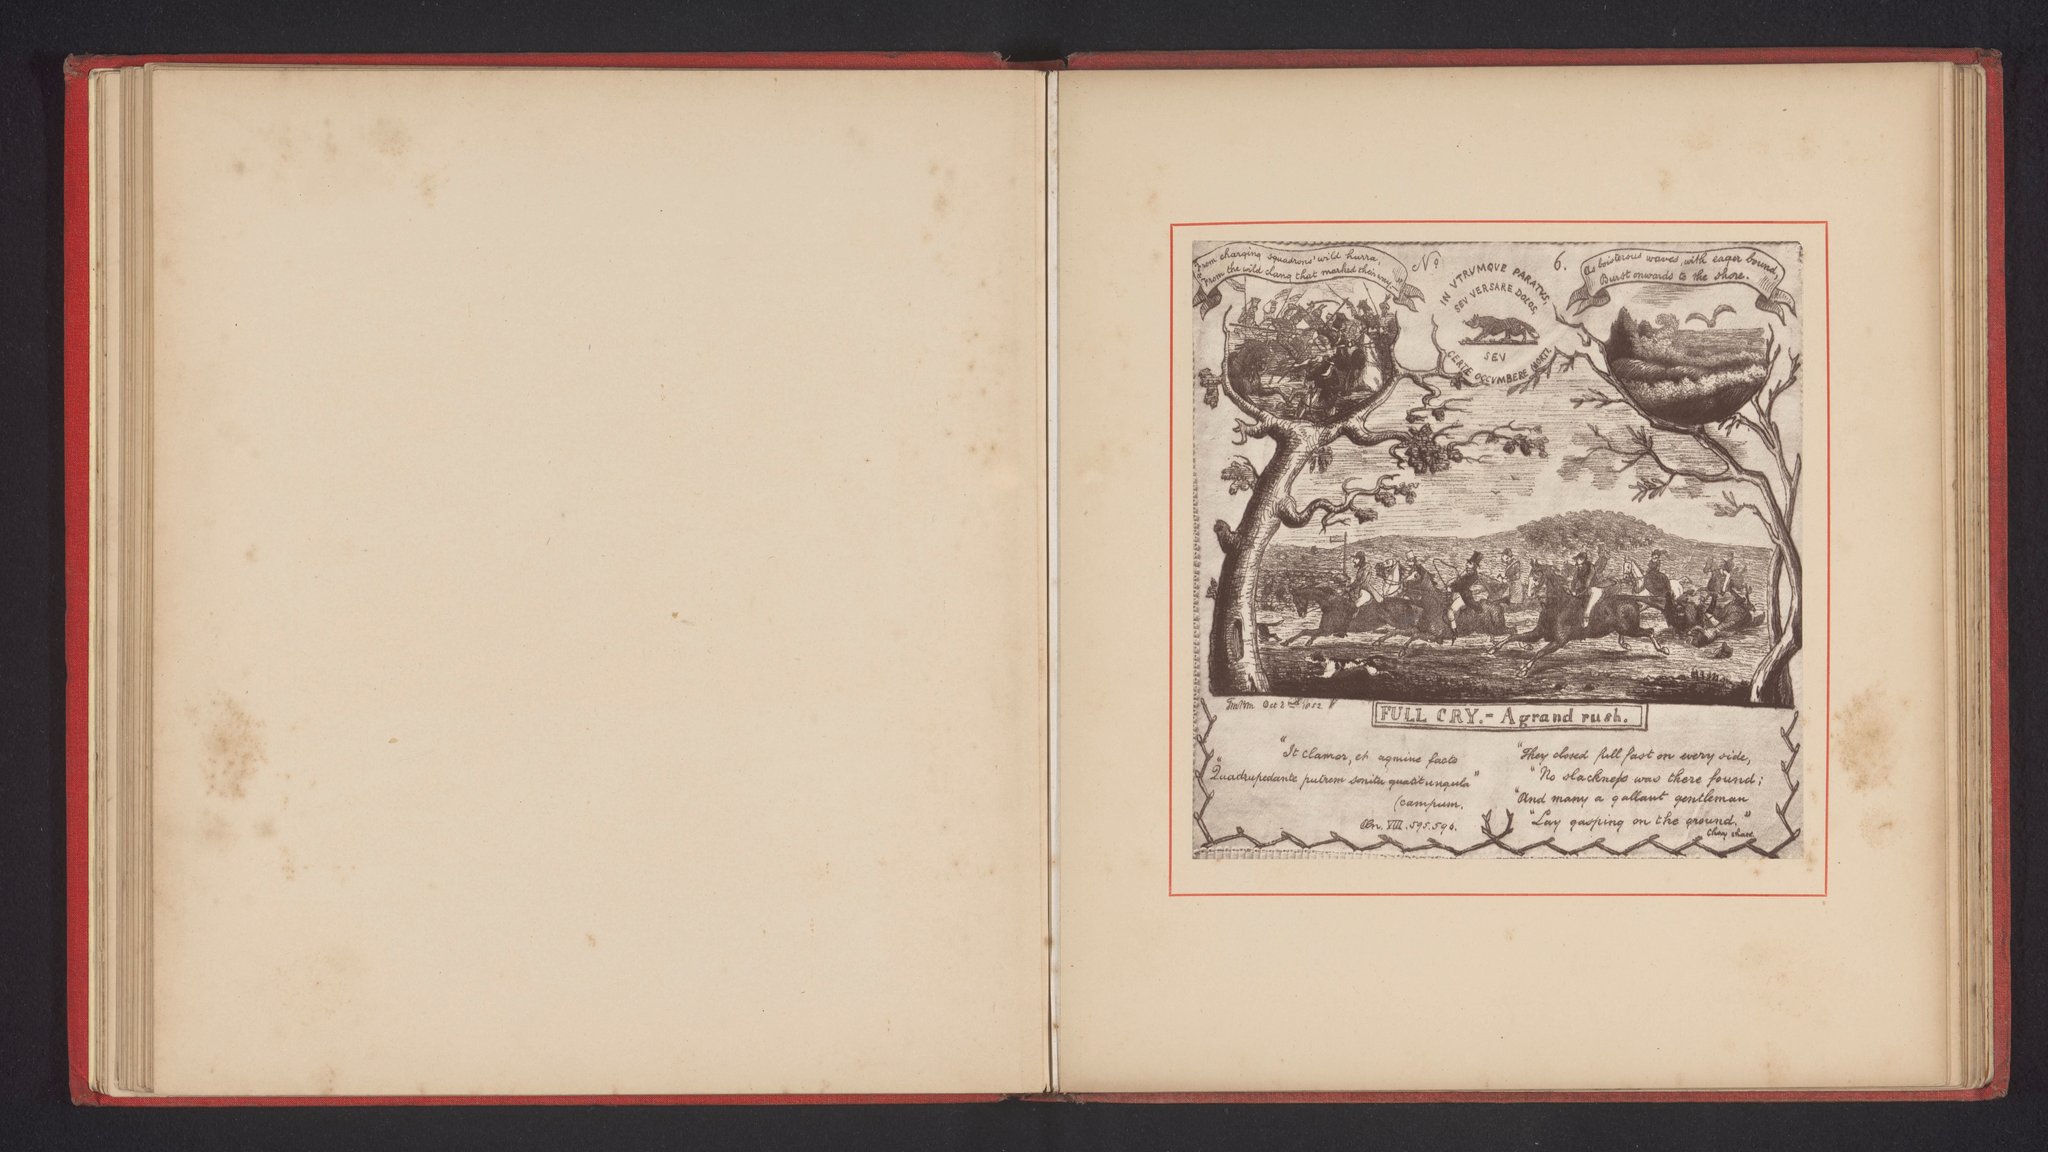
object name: reproduction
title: Full cry.- A grand rush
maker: Anonymous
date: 1875-1885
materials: paper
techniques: woodburytype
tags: riding a horse, ass, or mule; rider, horseman, drawing, sketch, hunting, chase, battle, fighting in general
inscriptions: inscription: ‘“It clamor [...] They closed full fast on every side, No slacknets was there found; And many a gallant gentleman Lay gasping on the ground. [...]”’, number: ‘No. 6.’